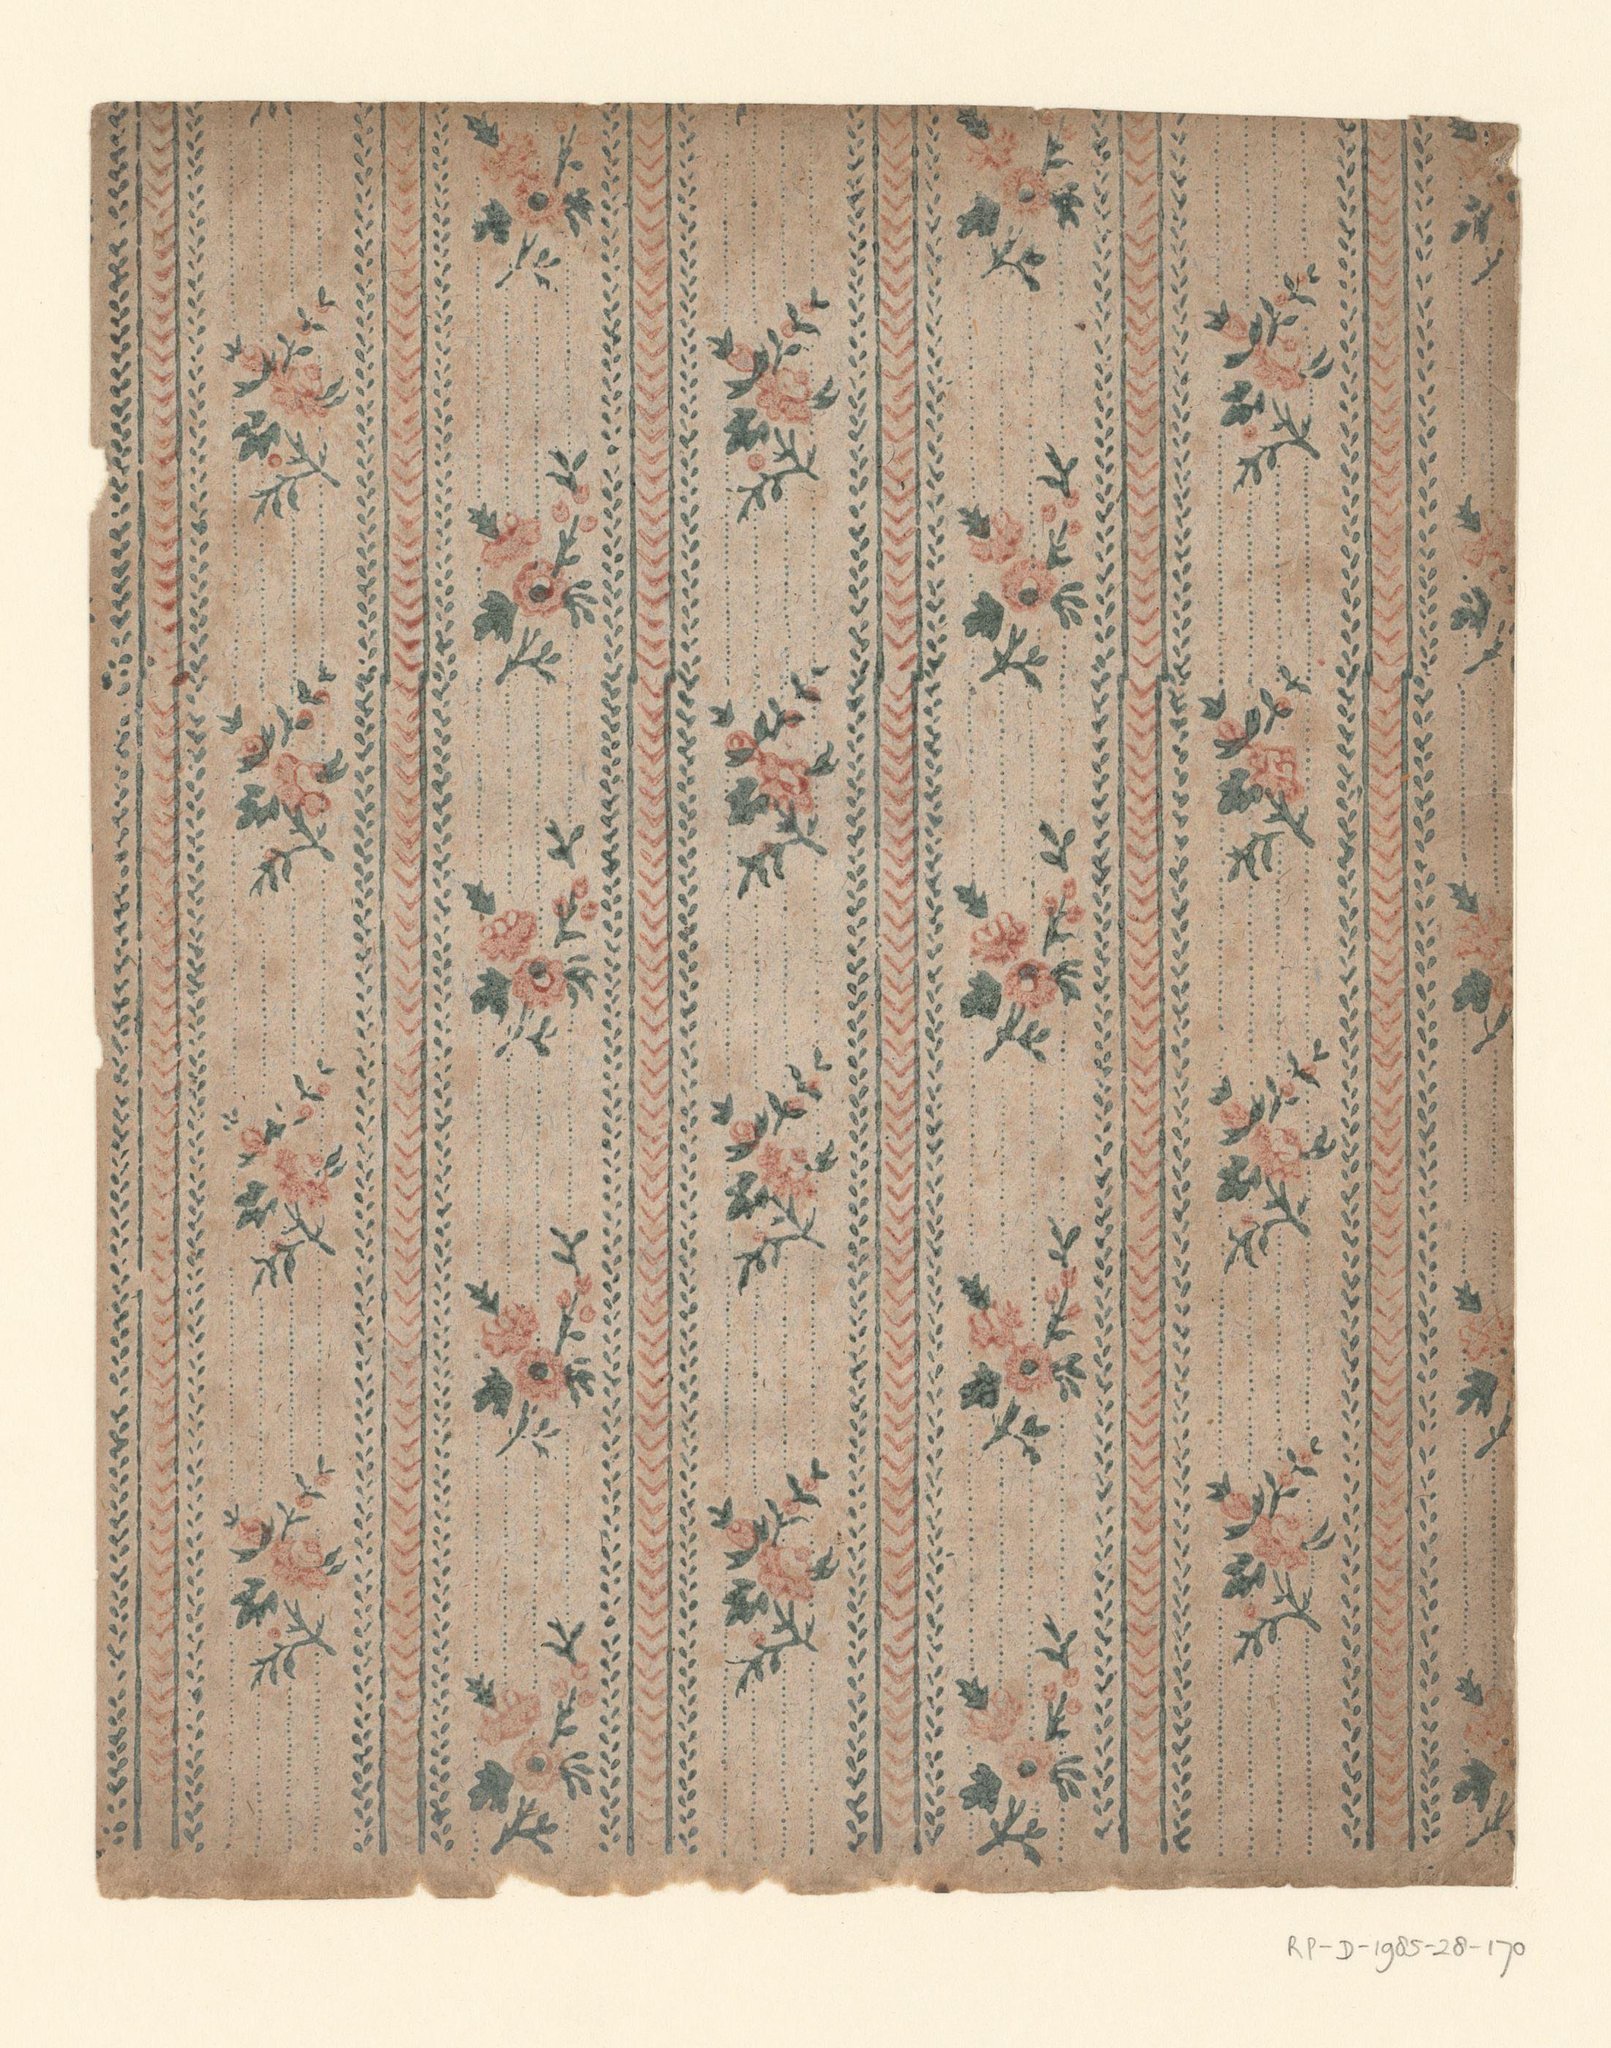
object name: wrapper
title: Blad met banenpatroon van bloemen op puntenfond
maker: Anonymous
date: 1750-1900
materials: paper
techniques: printing block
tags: ornament derived from plant forms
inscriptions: collector's mark: Lugt 2760, collector's mark: Lugt 2228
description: Blad met verticaal banenpatroon van bloemen op puntenfond, gescheiden door sierlijsten. Helft van een omslag.